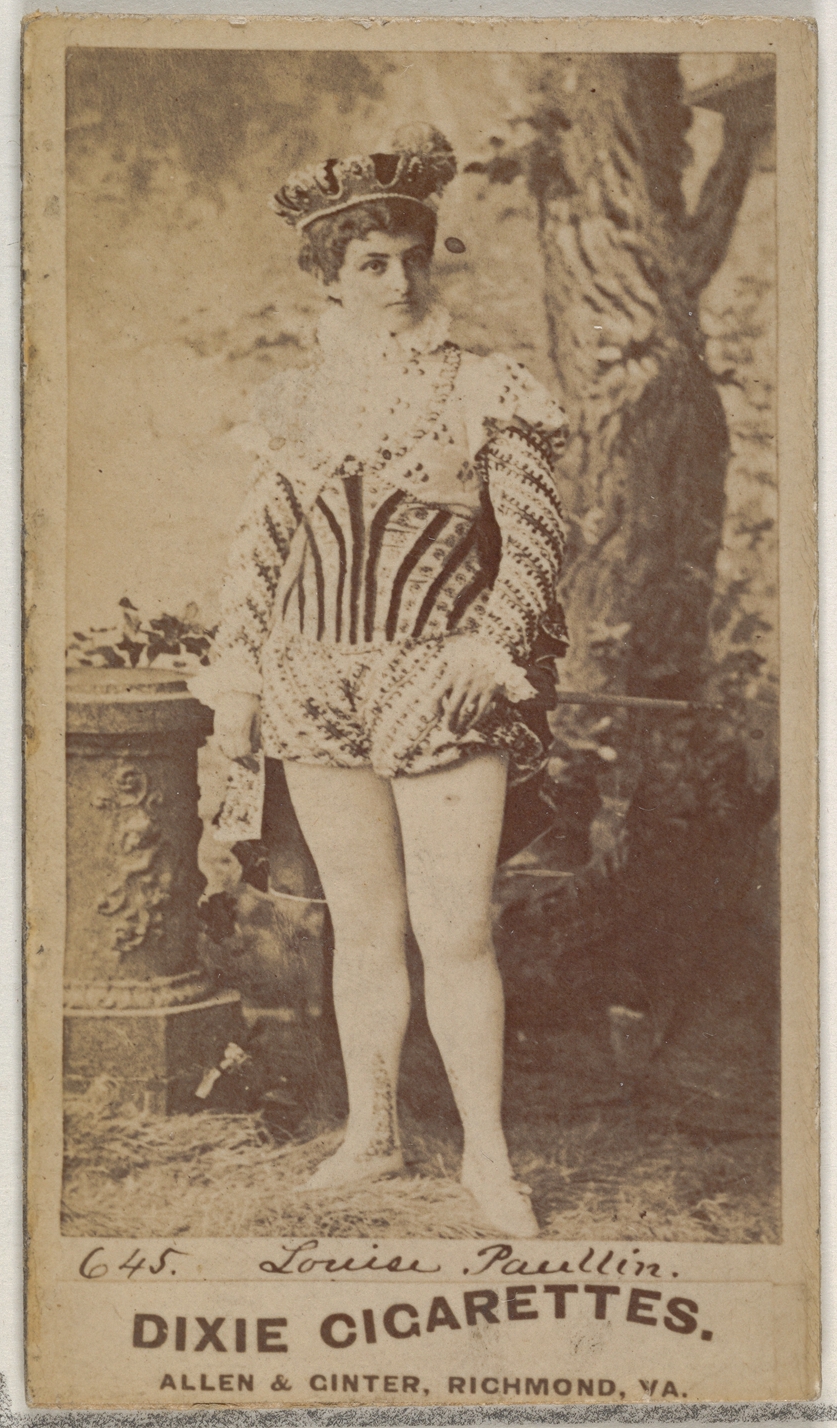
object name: photograph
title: Card 645, Louise Paullin, from the Actors and Actresses series (N45, Type 7) for Dixie Cigarettes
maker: allen & ginter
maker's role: publisher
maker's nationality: american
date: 1888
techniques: albumen silver print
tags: portraits,women,actresses